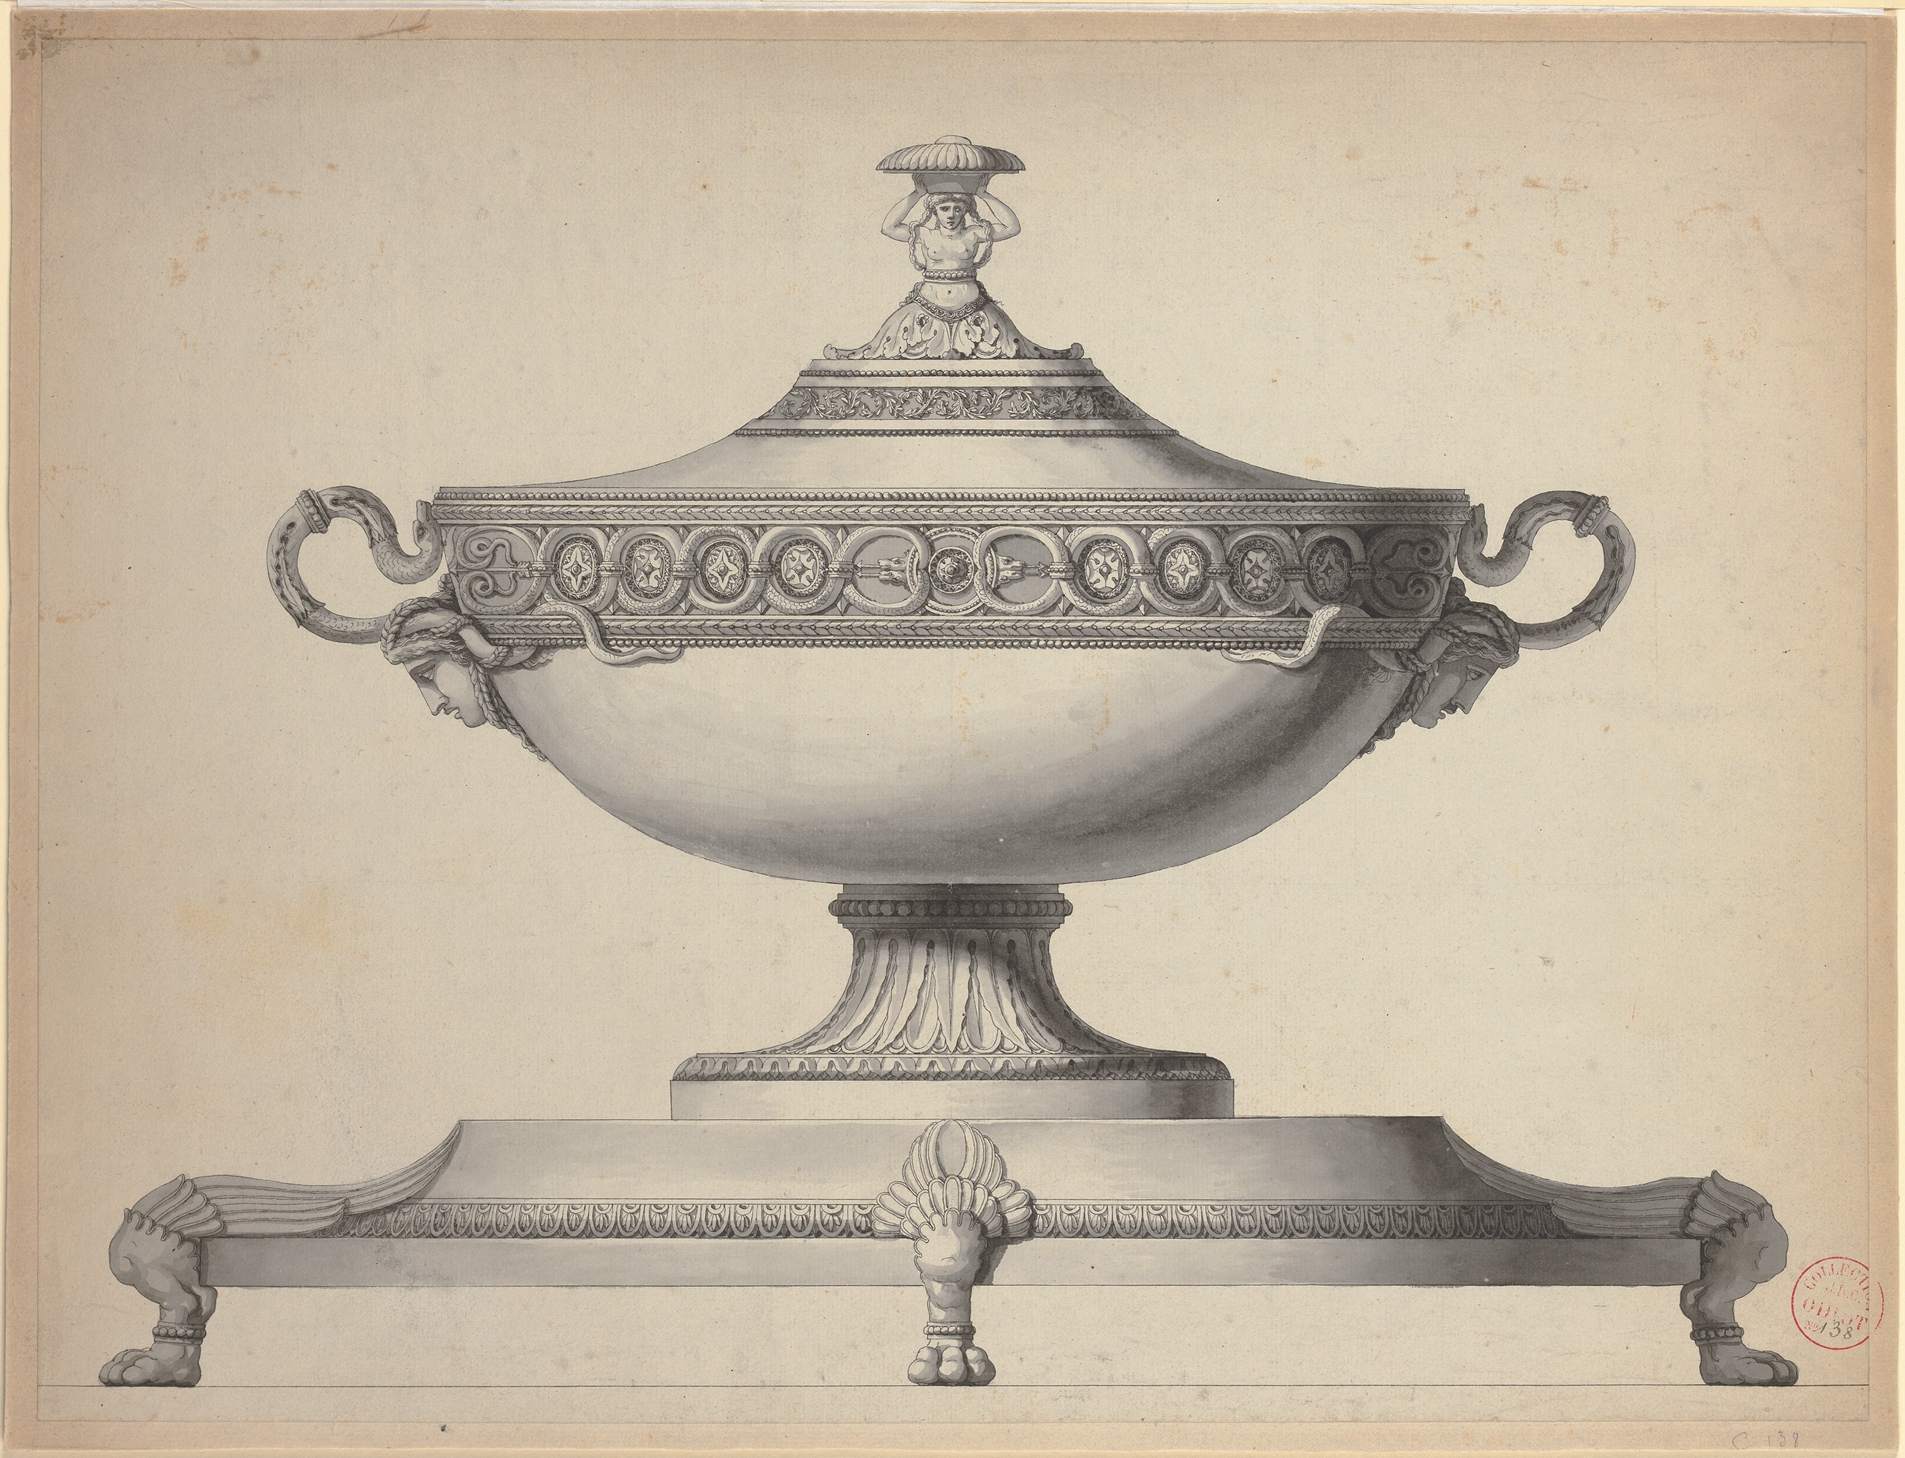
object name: drawing collection ornament architecture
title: Design for a Covered Tureen on a Footed Stand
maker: henri auguste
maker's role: artist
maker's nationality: french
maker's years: 1759-1816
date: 1770-1800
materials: ink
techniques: brush, pen, wash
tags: tureens